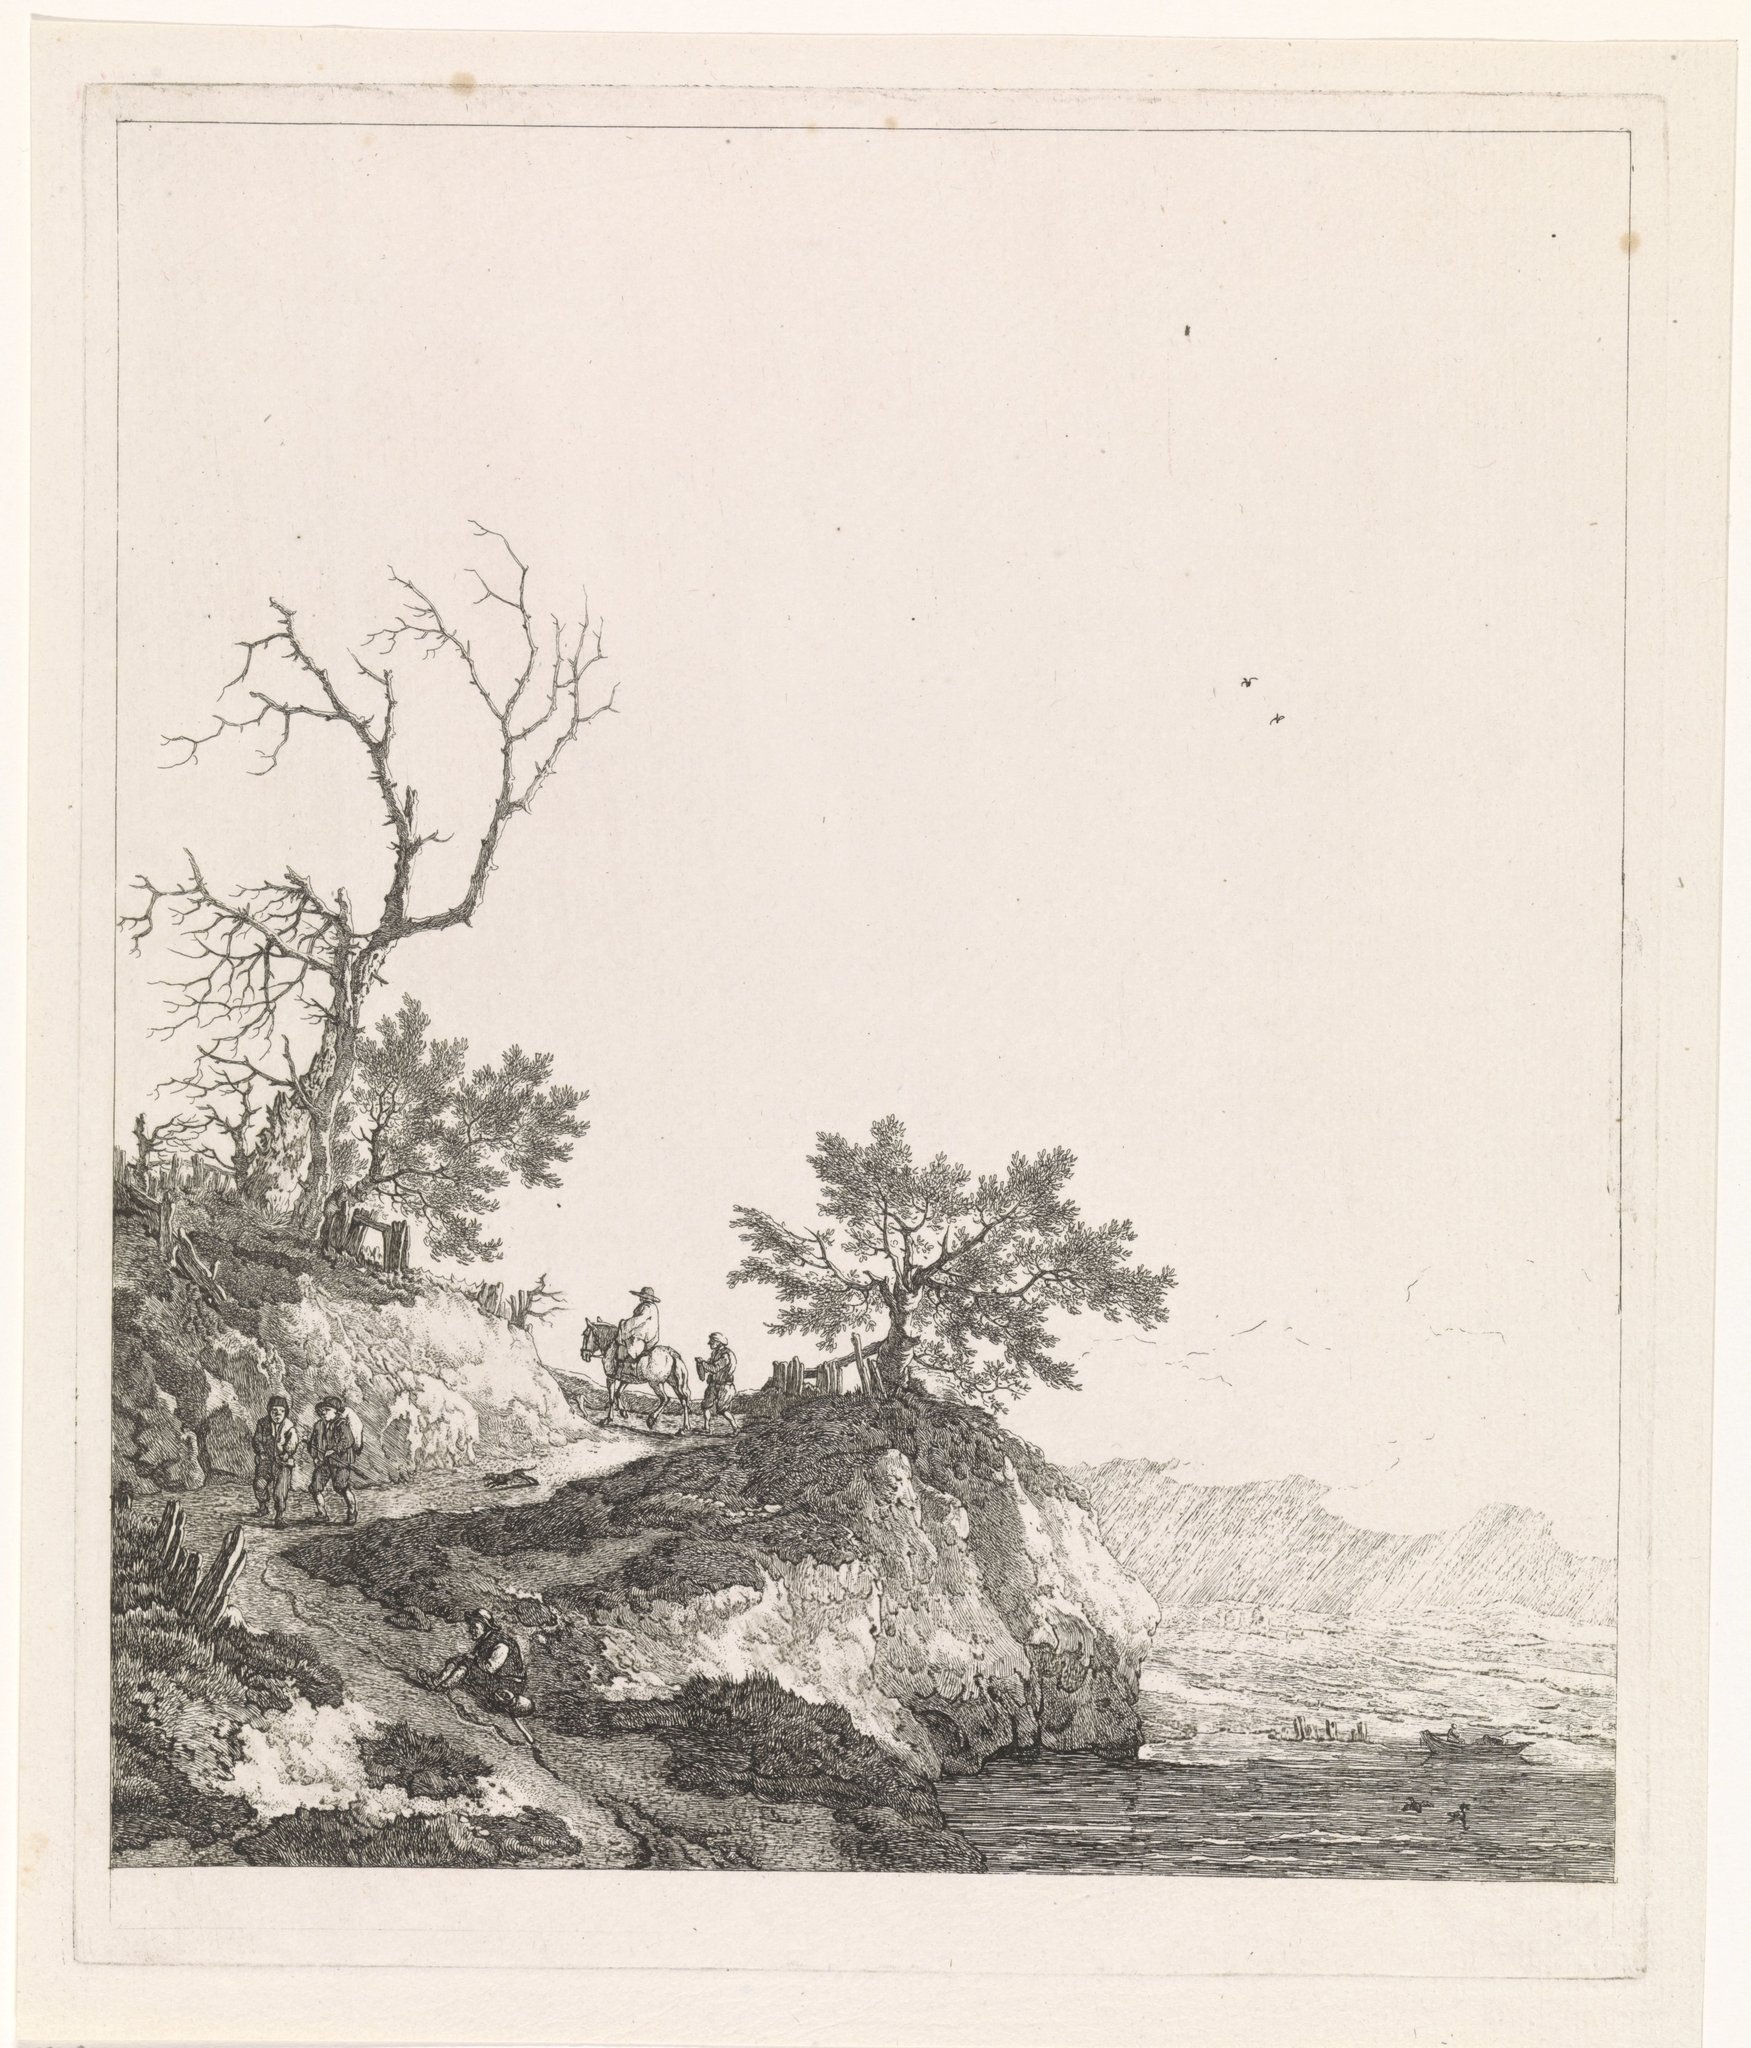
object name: print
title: Landschap met reizigers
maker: barend hendrik thier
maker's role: draughtsman, print maker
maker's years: 1743-1811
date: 1755-1811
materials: paper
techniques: etching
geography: netherlands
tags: beggar, landscapes in the temperate zone (+ landscape with figures, staffage)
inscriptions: collector's mark: Lugt 240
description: In een landschap lopen reizigers op een weg. Een bedelaar loopt op de man te paard af. Rechts een roeibot op het water. Daarboven een regenlucht.